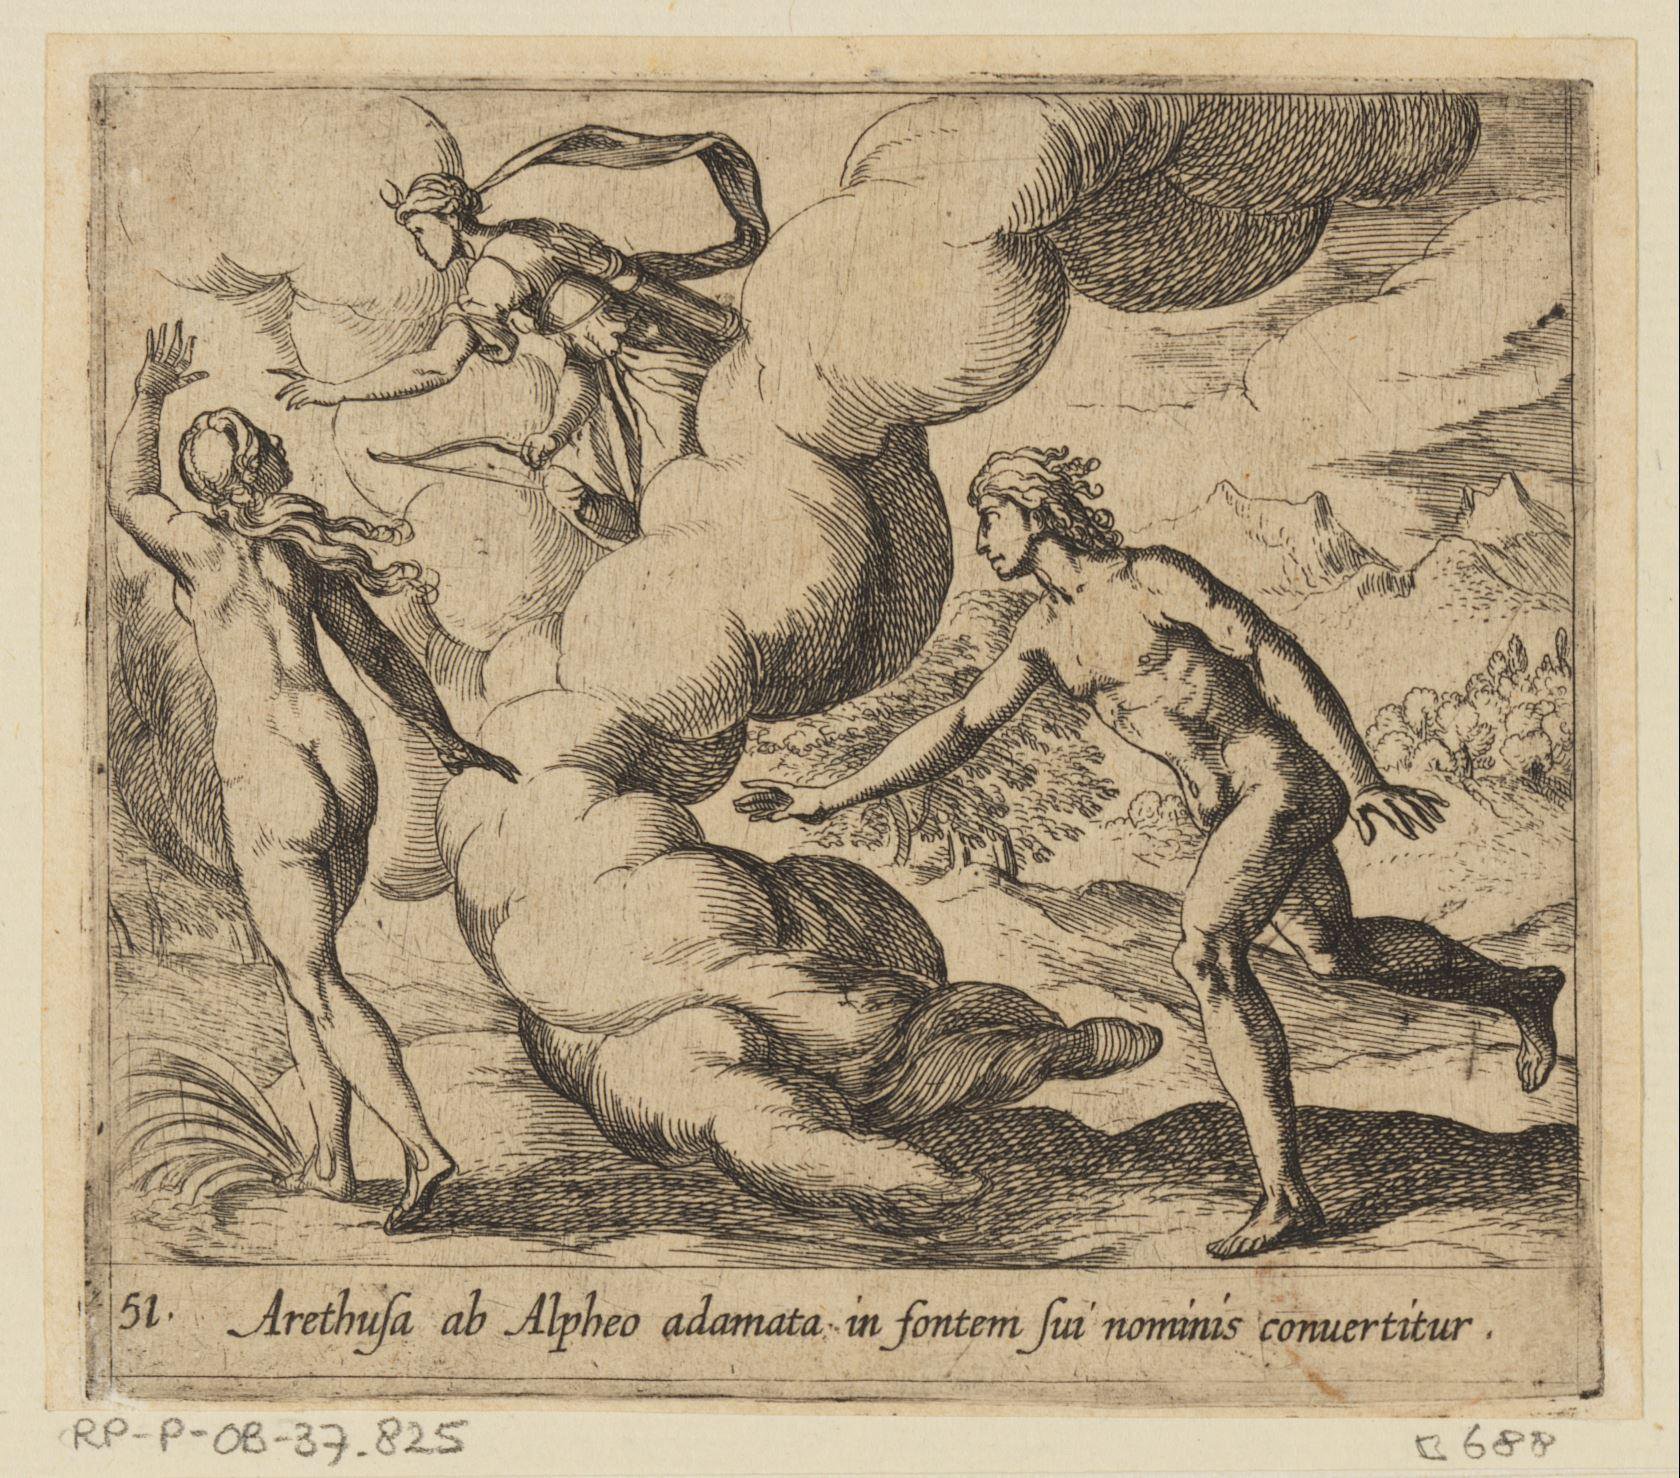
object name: print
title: Metamorfosen van Ovidius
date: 1606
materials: paper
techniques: etching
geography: italy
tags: arethusa is turned into a fountain when pursued by the handsome hunter alpheus (pausanias v 7, 2)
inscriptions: collector's mark: Lugt 240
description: Deze prent maakt deel uit van een reeks van 150 prenten (+ titelprent) met voorstellingen van de Metamorfosen van Ovidius.